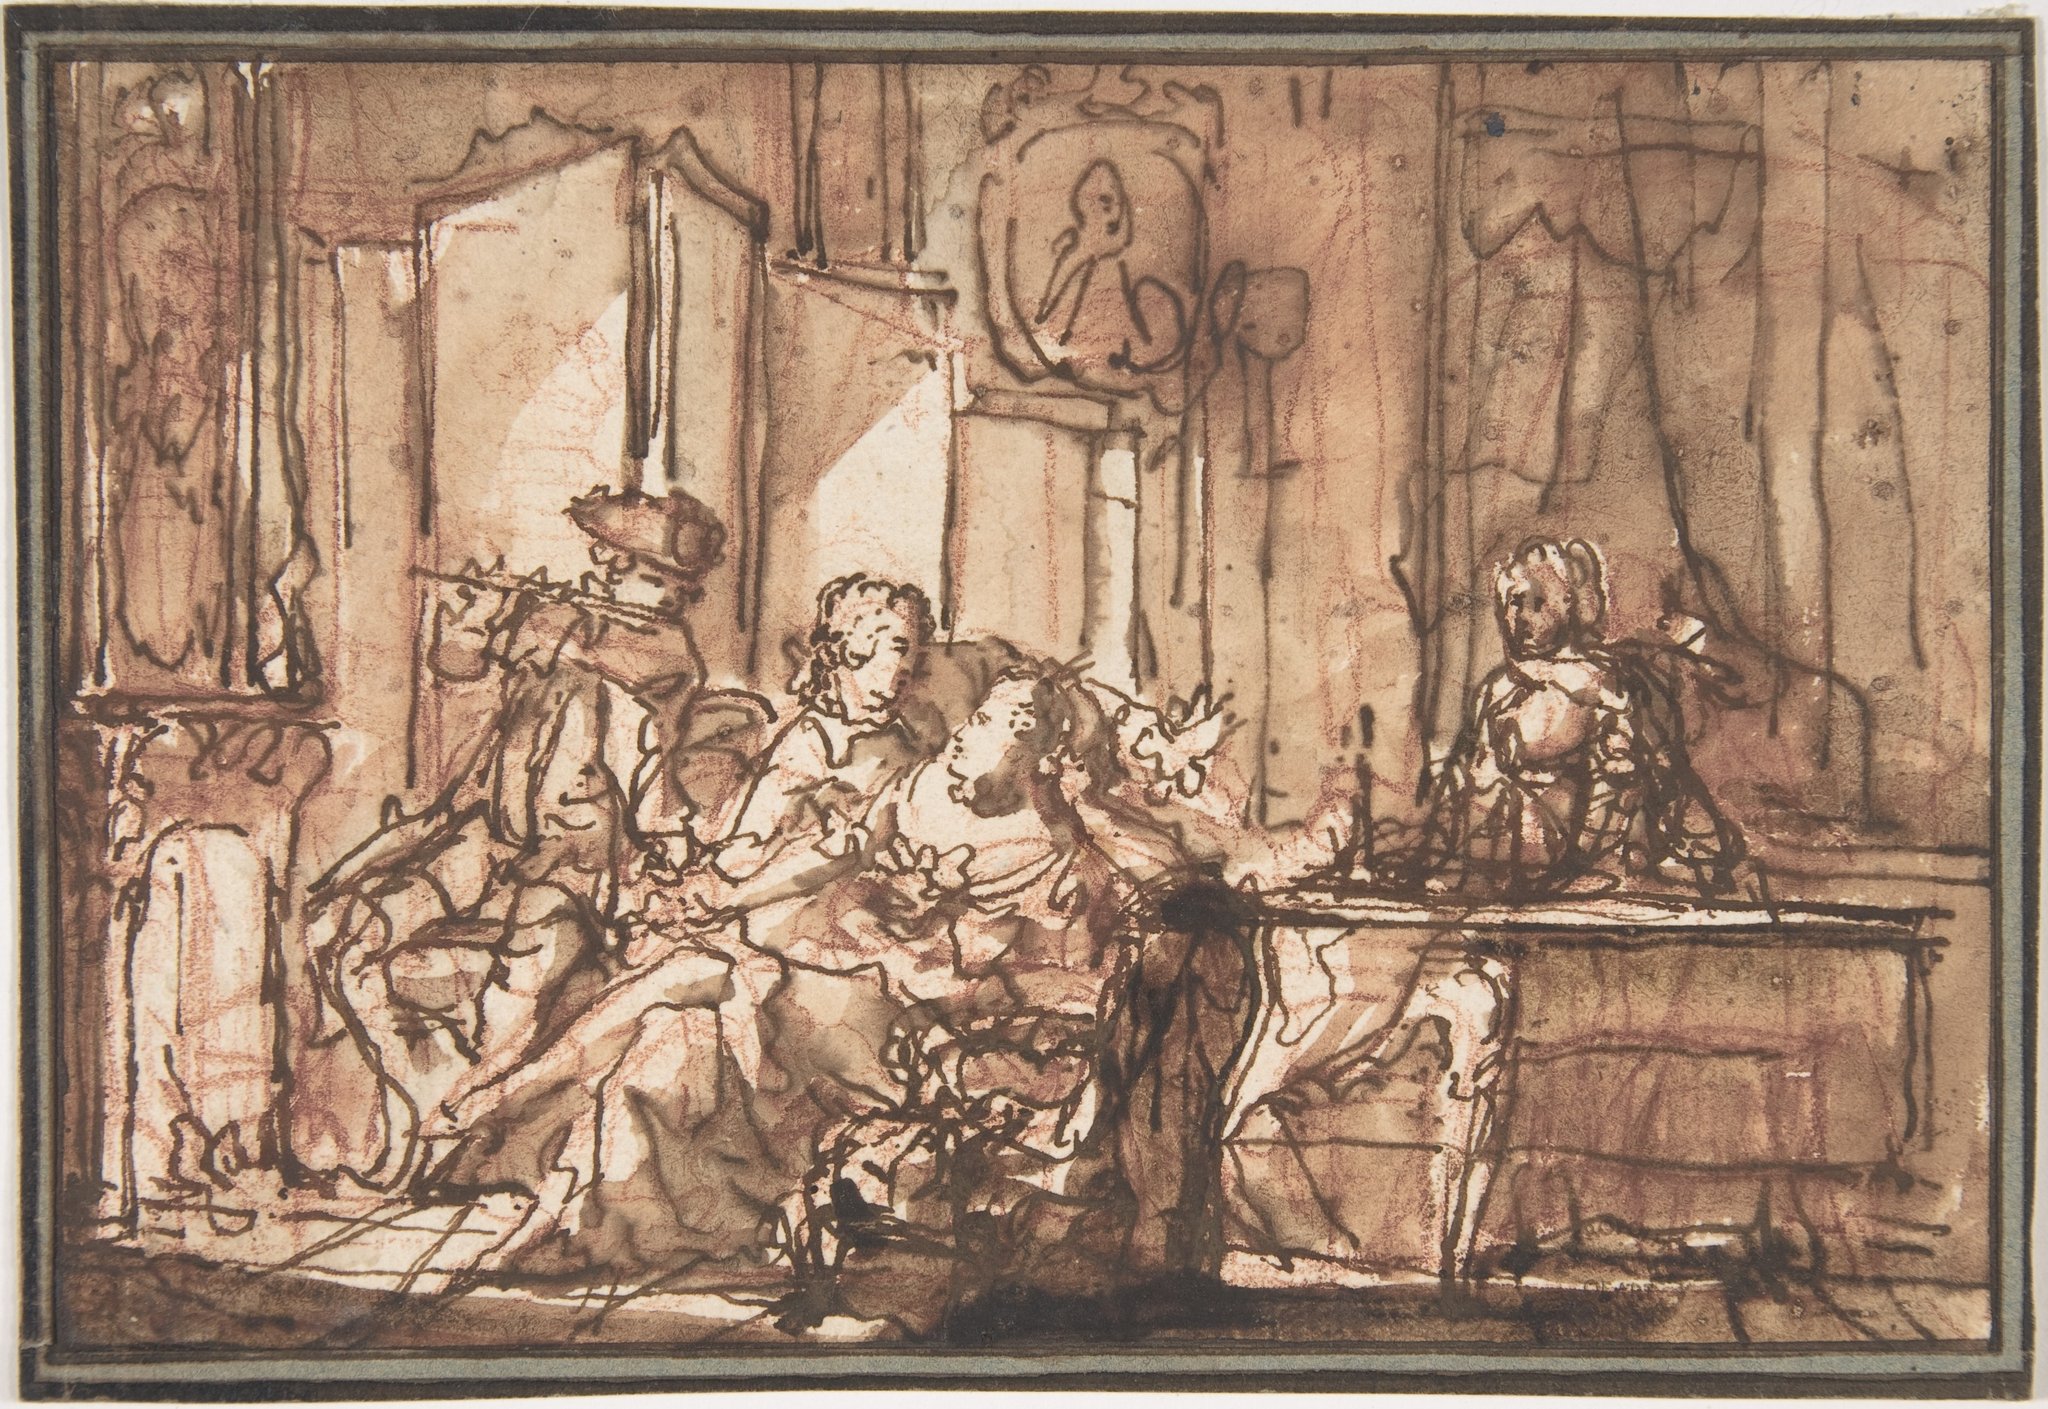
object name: drawing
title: Interior with Figures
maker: anonymous, french, 18th century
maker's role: artist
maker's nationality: french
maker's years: 1700-1800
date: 1701-1800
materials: chalk, ink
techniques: brush, pen, wash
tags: interiors,men,women,flutes